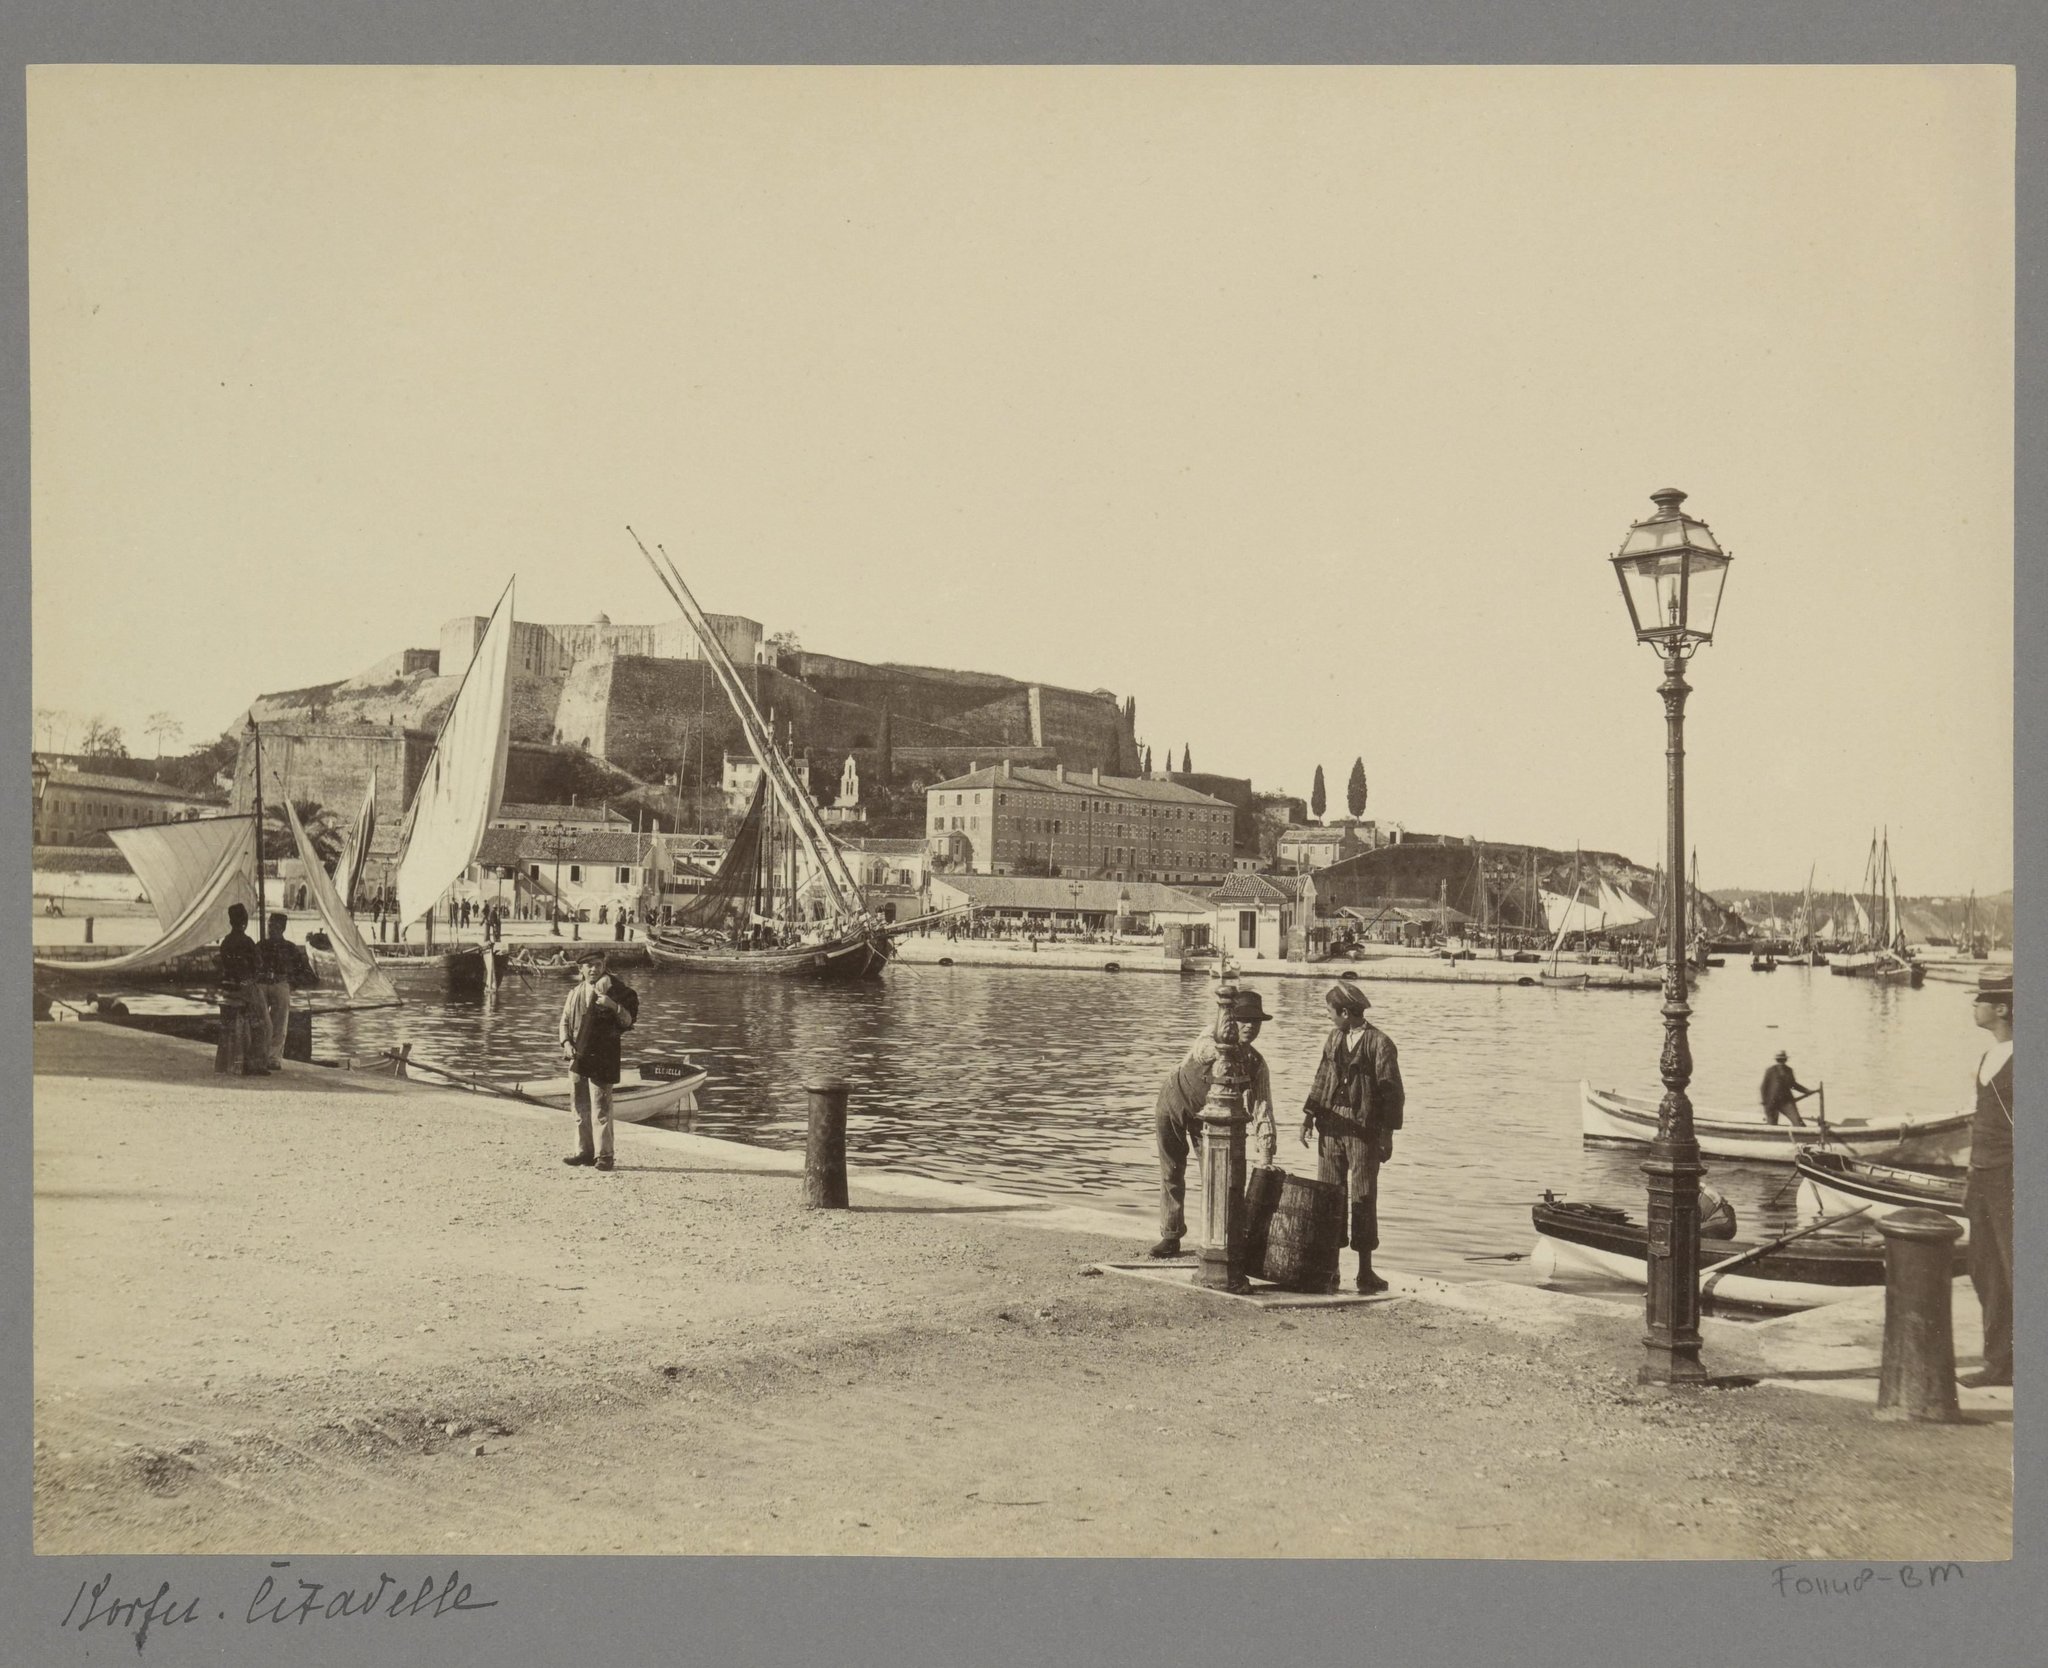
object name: album leaf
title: Havengezicht op Corfu met op de achtergrond de citadel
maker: Anonymous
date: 1895-1905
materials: paper, photographic support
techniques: albumen print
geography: corfu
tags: harbour (+ view ~ vehicle, ship, etc.), fortified city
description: Onderdeel van Reisalbum met foto's van bezienswaardigheden in Griekenland en Egypte.